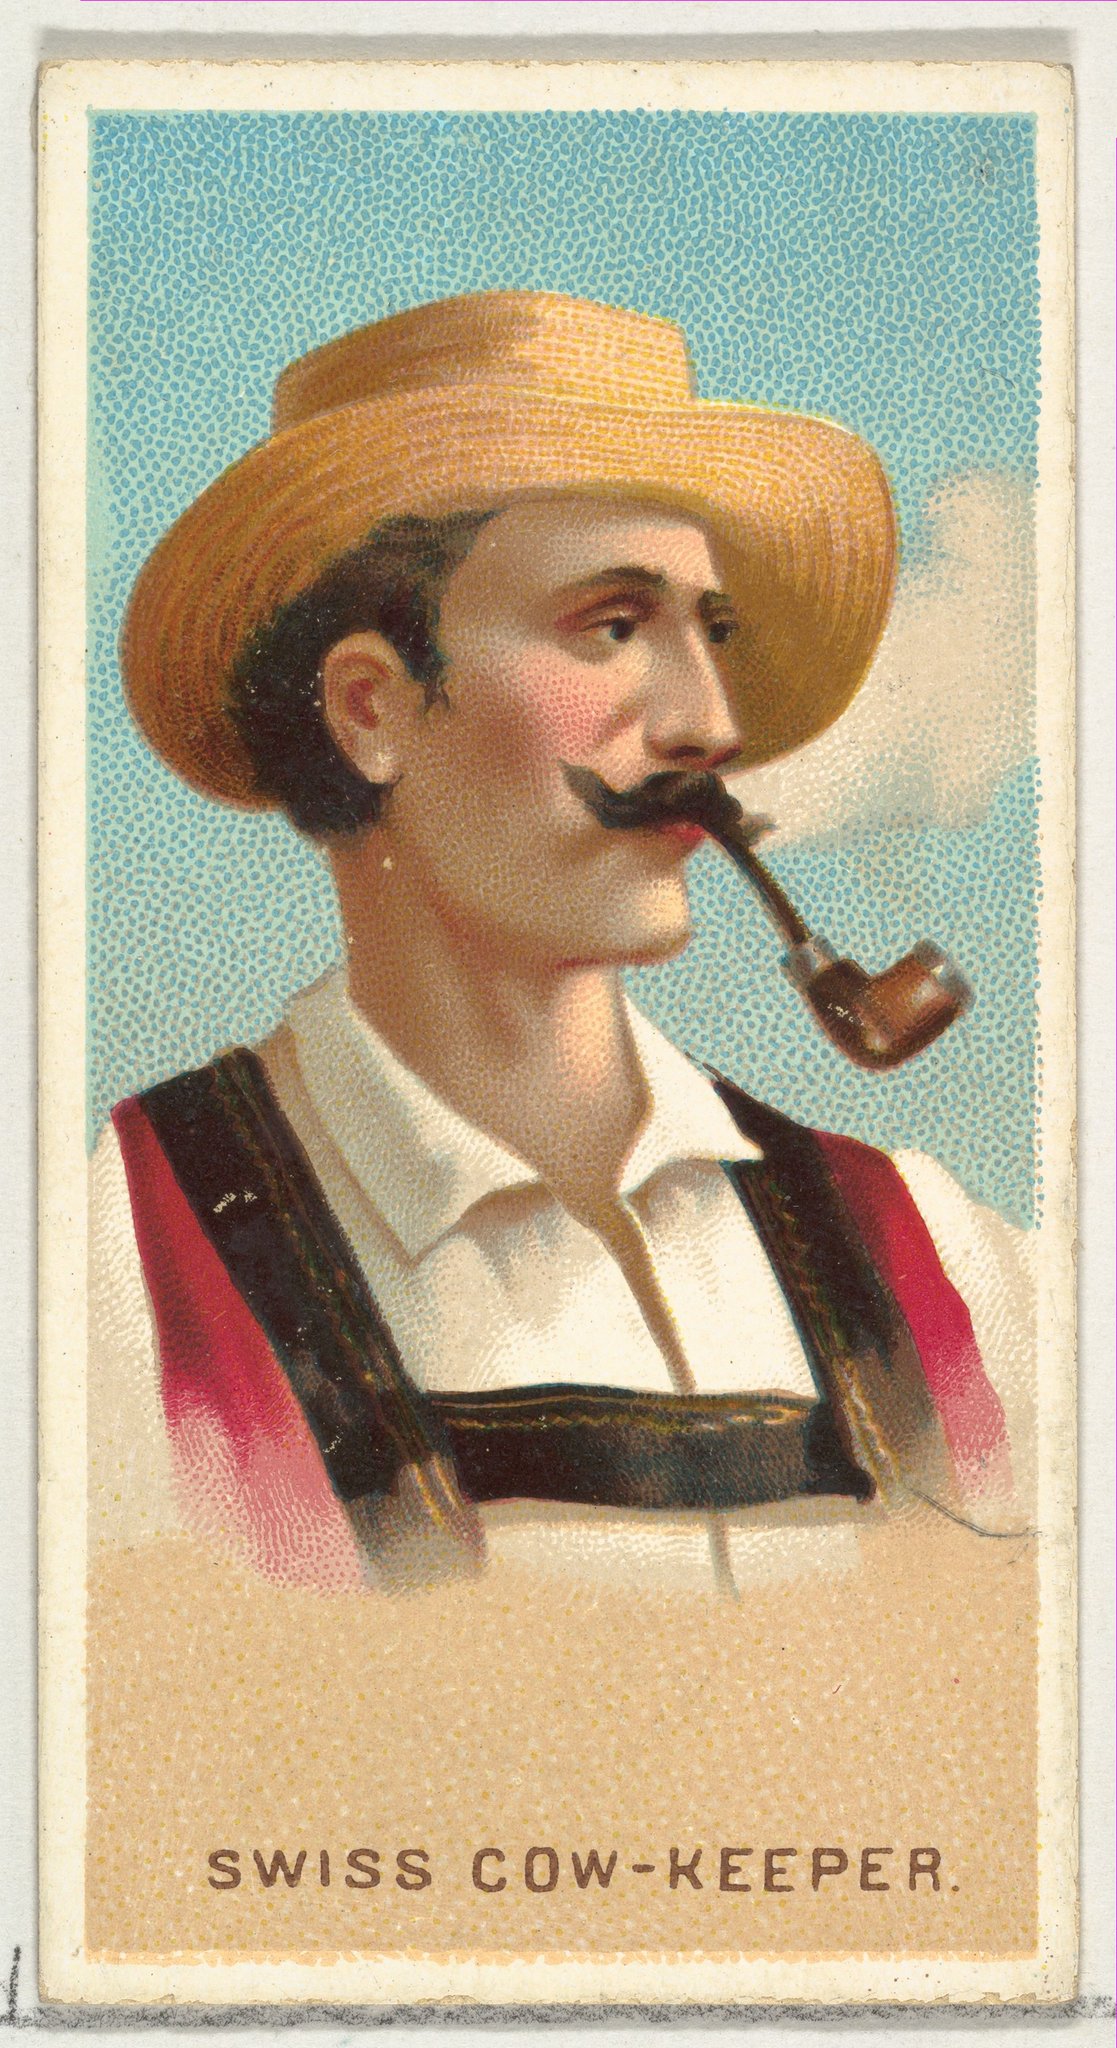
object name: print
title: Swiss Cow-Keeper, from World's Smokers series (N33) for Allen & Ginter Cigarettes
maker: allen & ginter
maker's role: publisher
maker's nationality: american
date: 1888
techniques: color lithograph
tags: men,smoking